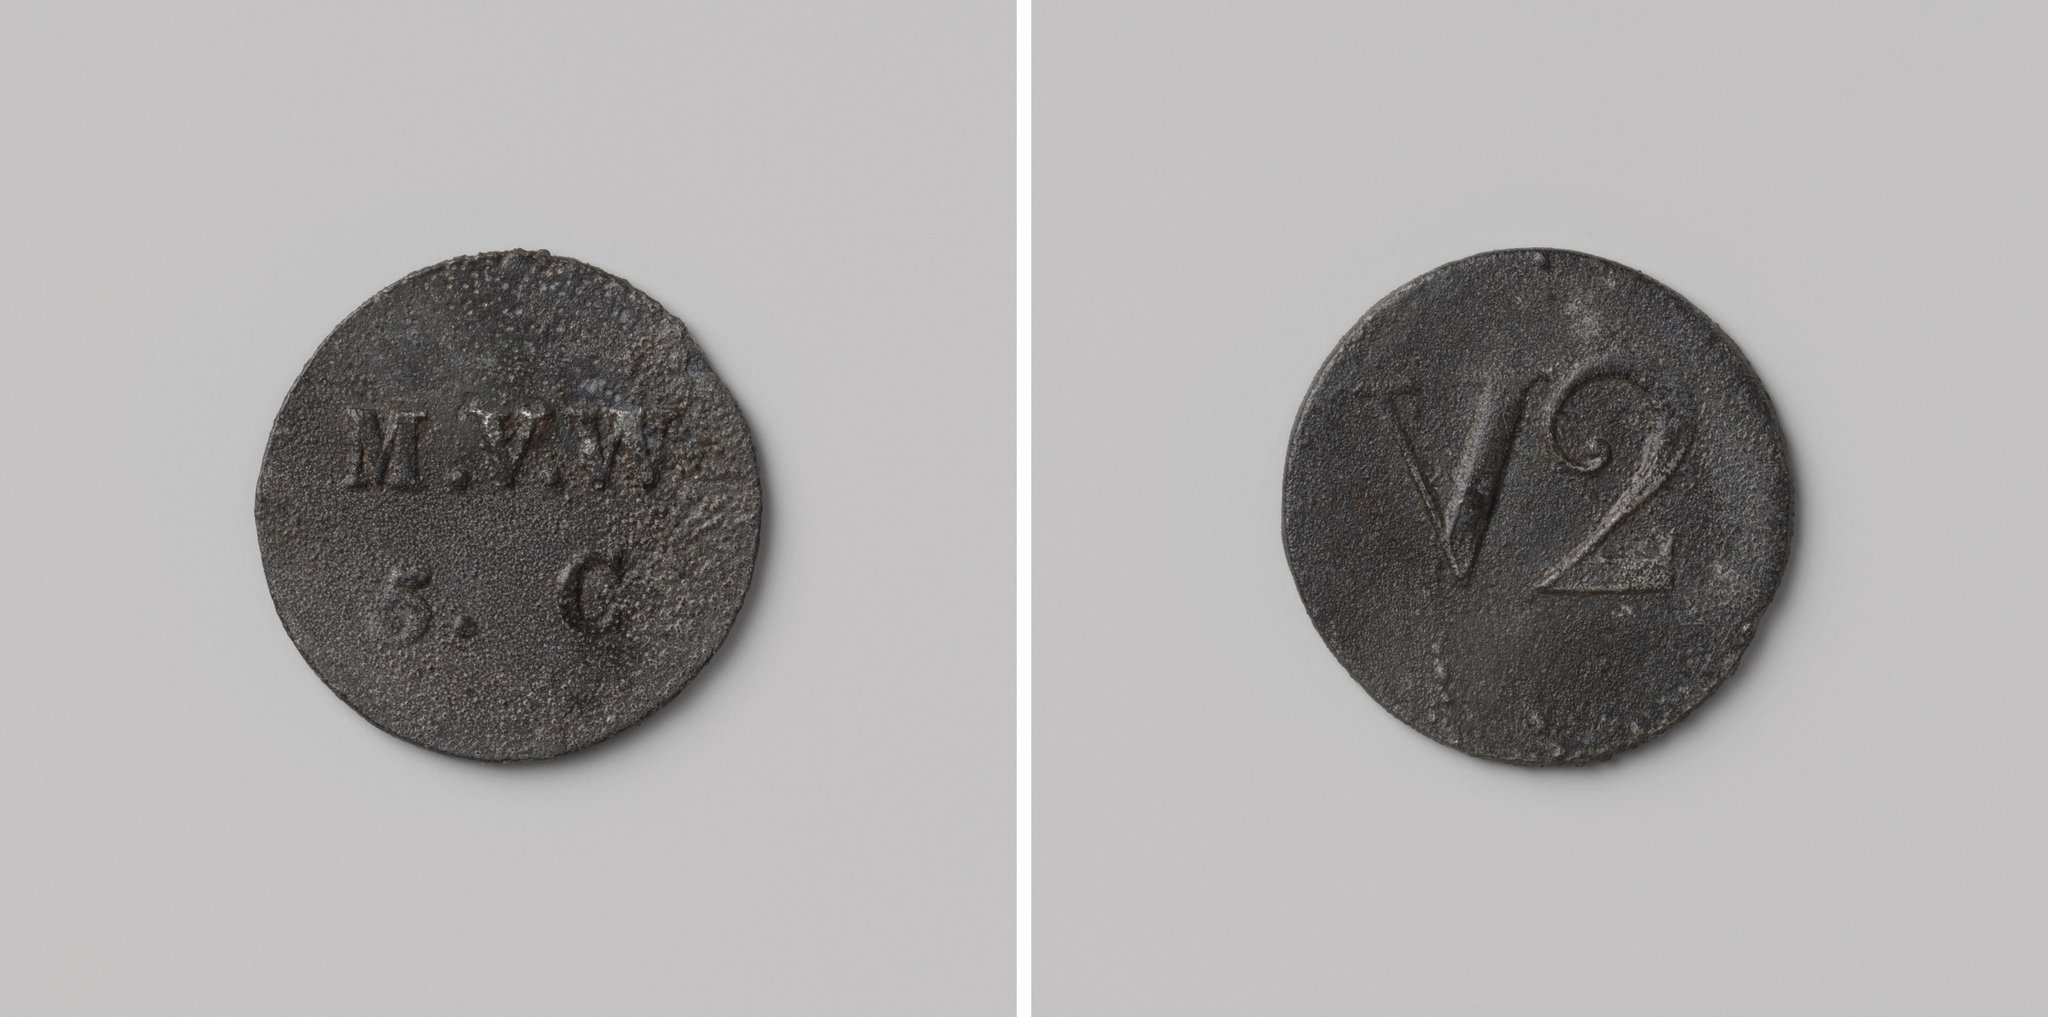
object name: vijf cent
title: Tweede gesticht van de strafkolonie Veenhuizen, huismunt geslagen op last van de Maatschappij van Weldadigheid ter waarde van vijf cent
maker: Anonymous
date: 1818-1859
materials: zinc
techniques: striking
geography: netherlands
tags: maatschappij van weldadigheid, veenhuizen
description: Zinken munt. Voorzijde: opschrift boven waardeaanduiding. Keerzijde: opschrift V 2.